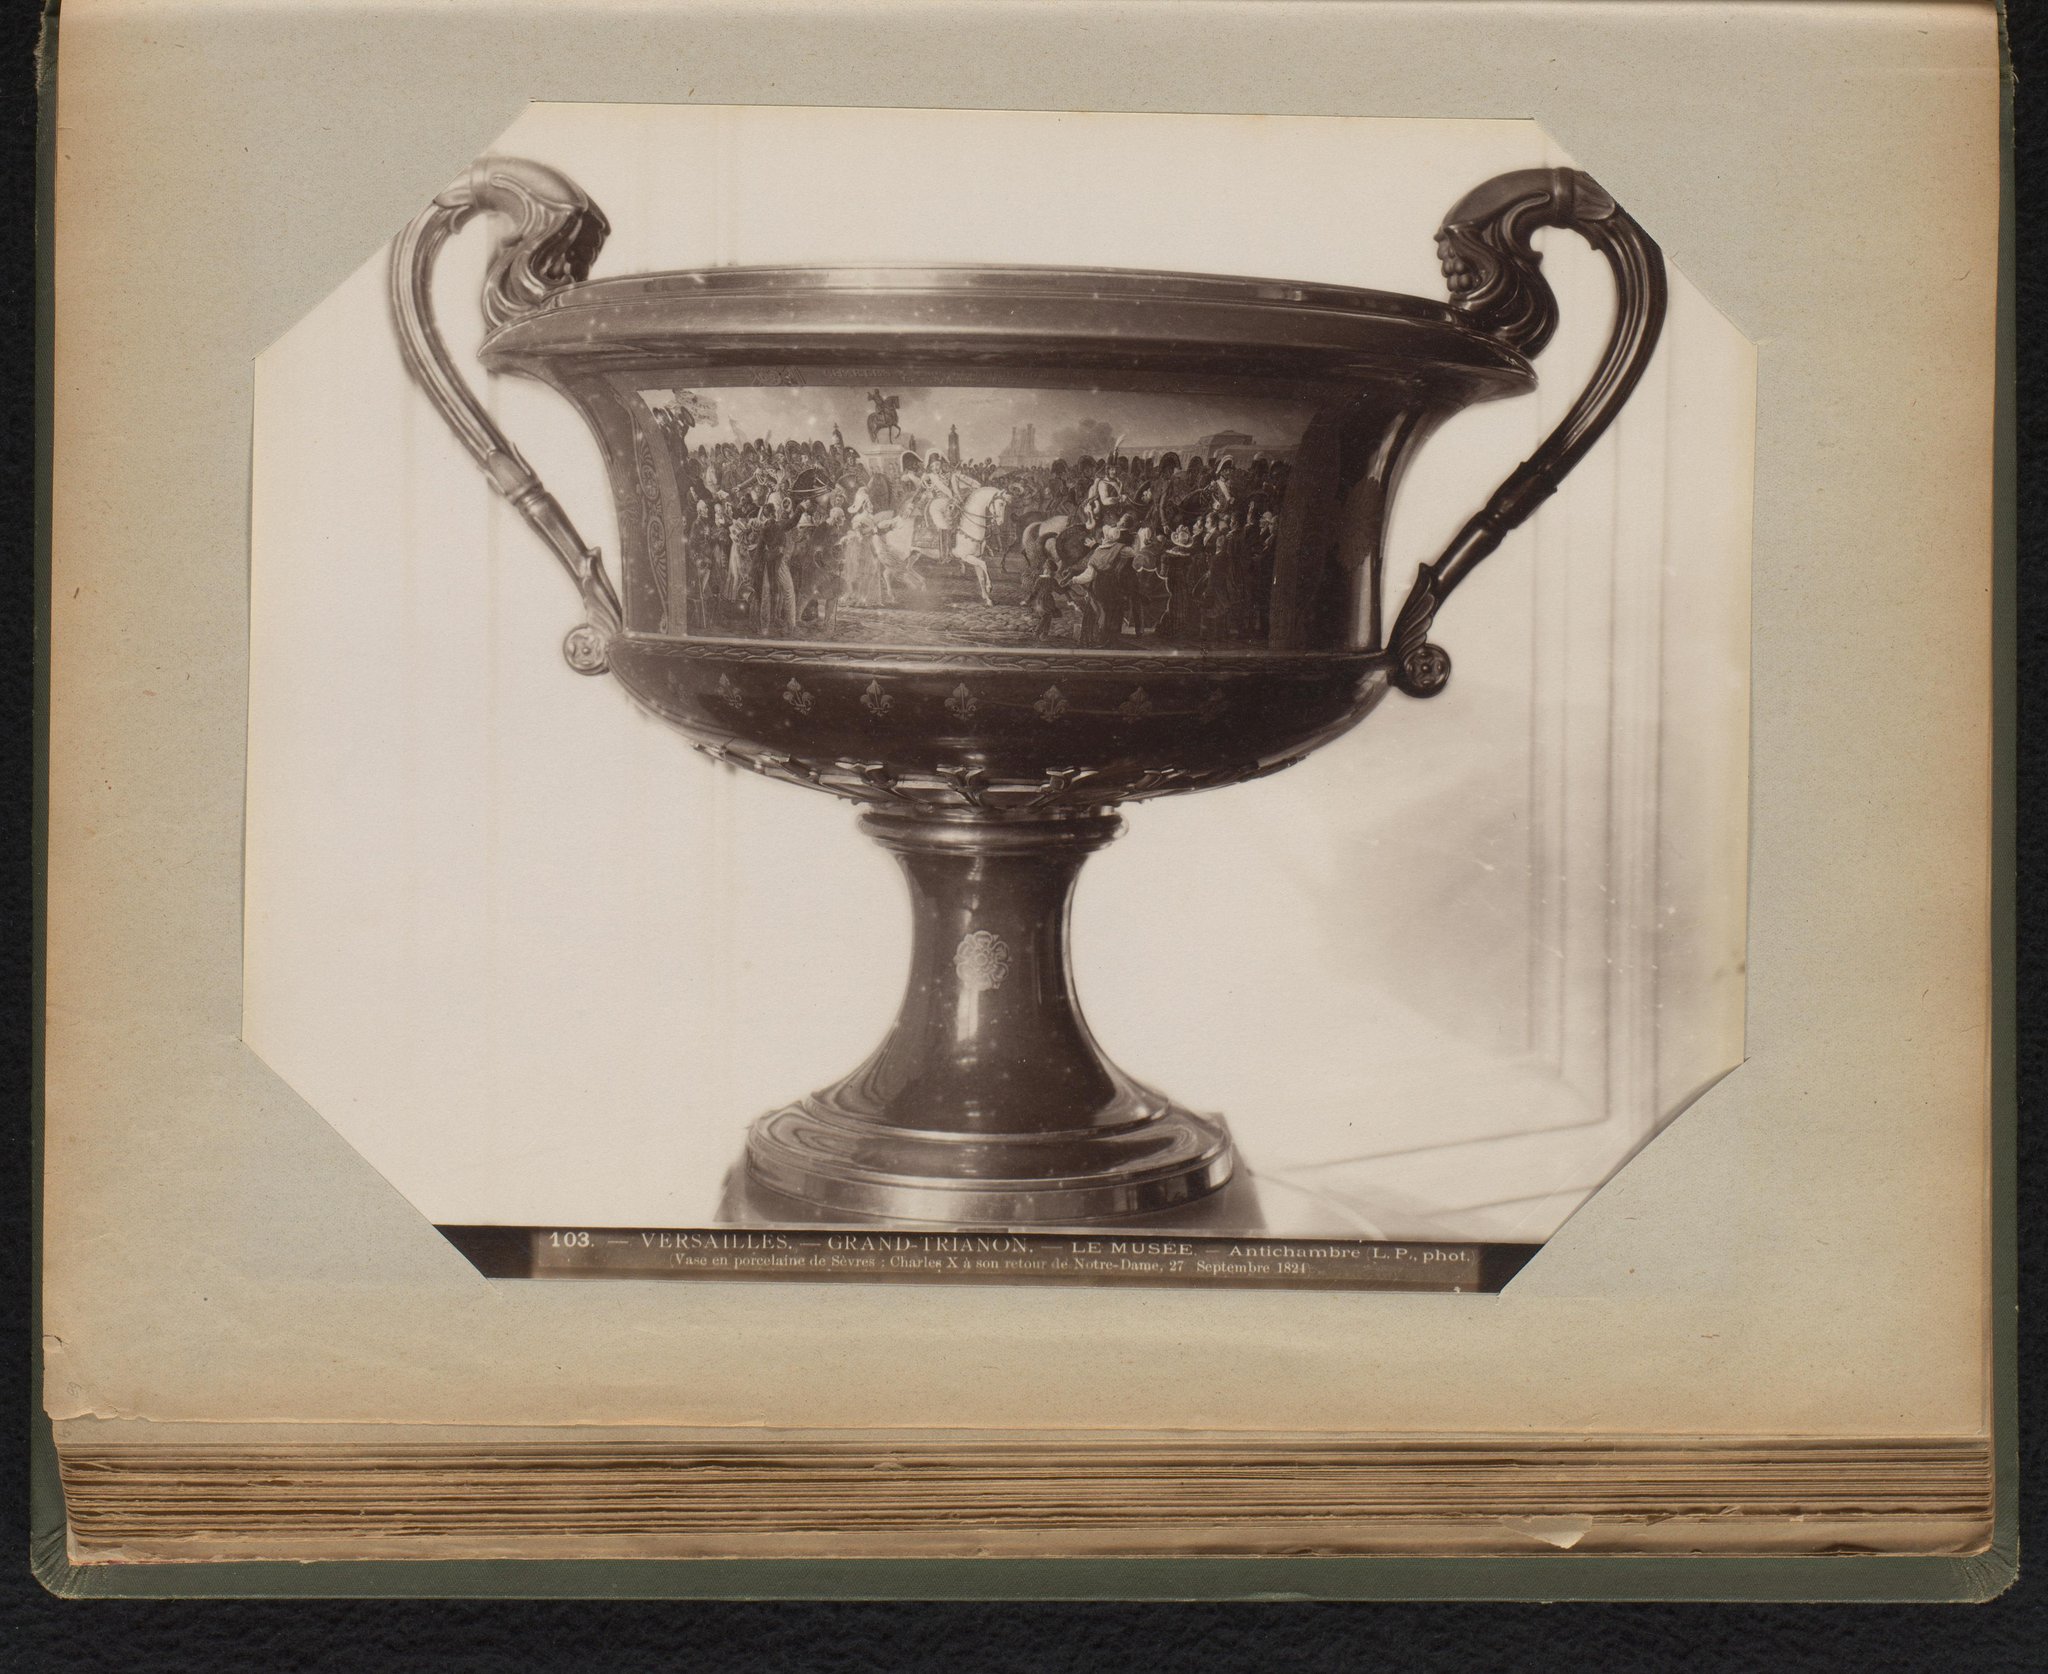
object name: photograph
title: Beschilderde porseleinen vaas waarop afgebeeld Charles bij zijn terug keer in Notre Dame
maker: Anonymous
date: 1860-1900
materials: paper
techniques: albumen print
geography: france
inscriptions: annotation: ‘103. Versailles - Grand Trianon - Le Musee - Antichambre (L.P. Phot) (vase en porcelaine de Sevres: Charles X a son retour de Notre-Dame, 27 septembre 1824).’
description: Onderdeel van een serie met betrekking tot het interieur van het paleis van Versailles met kroonluchters, deuren, portalen en meubelstukken.